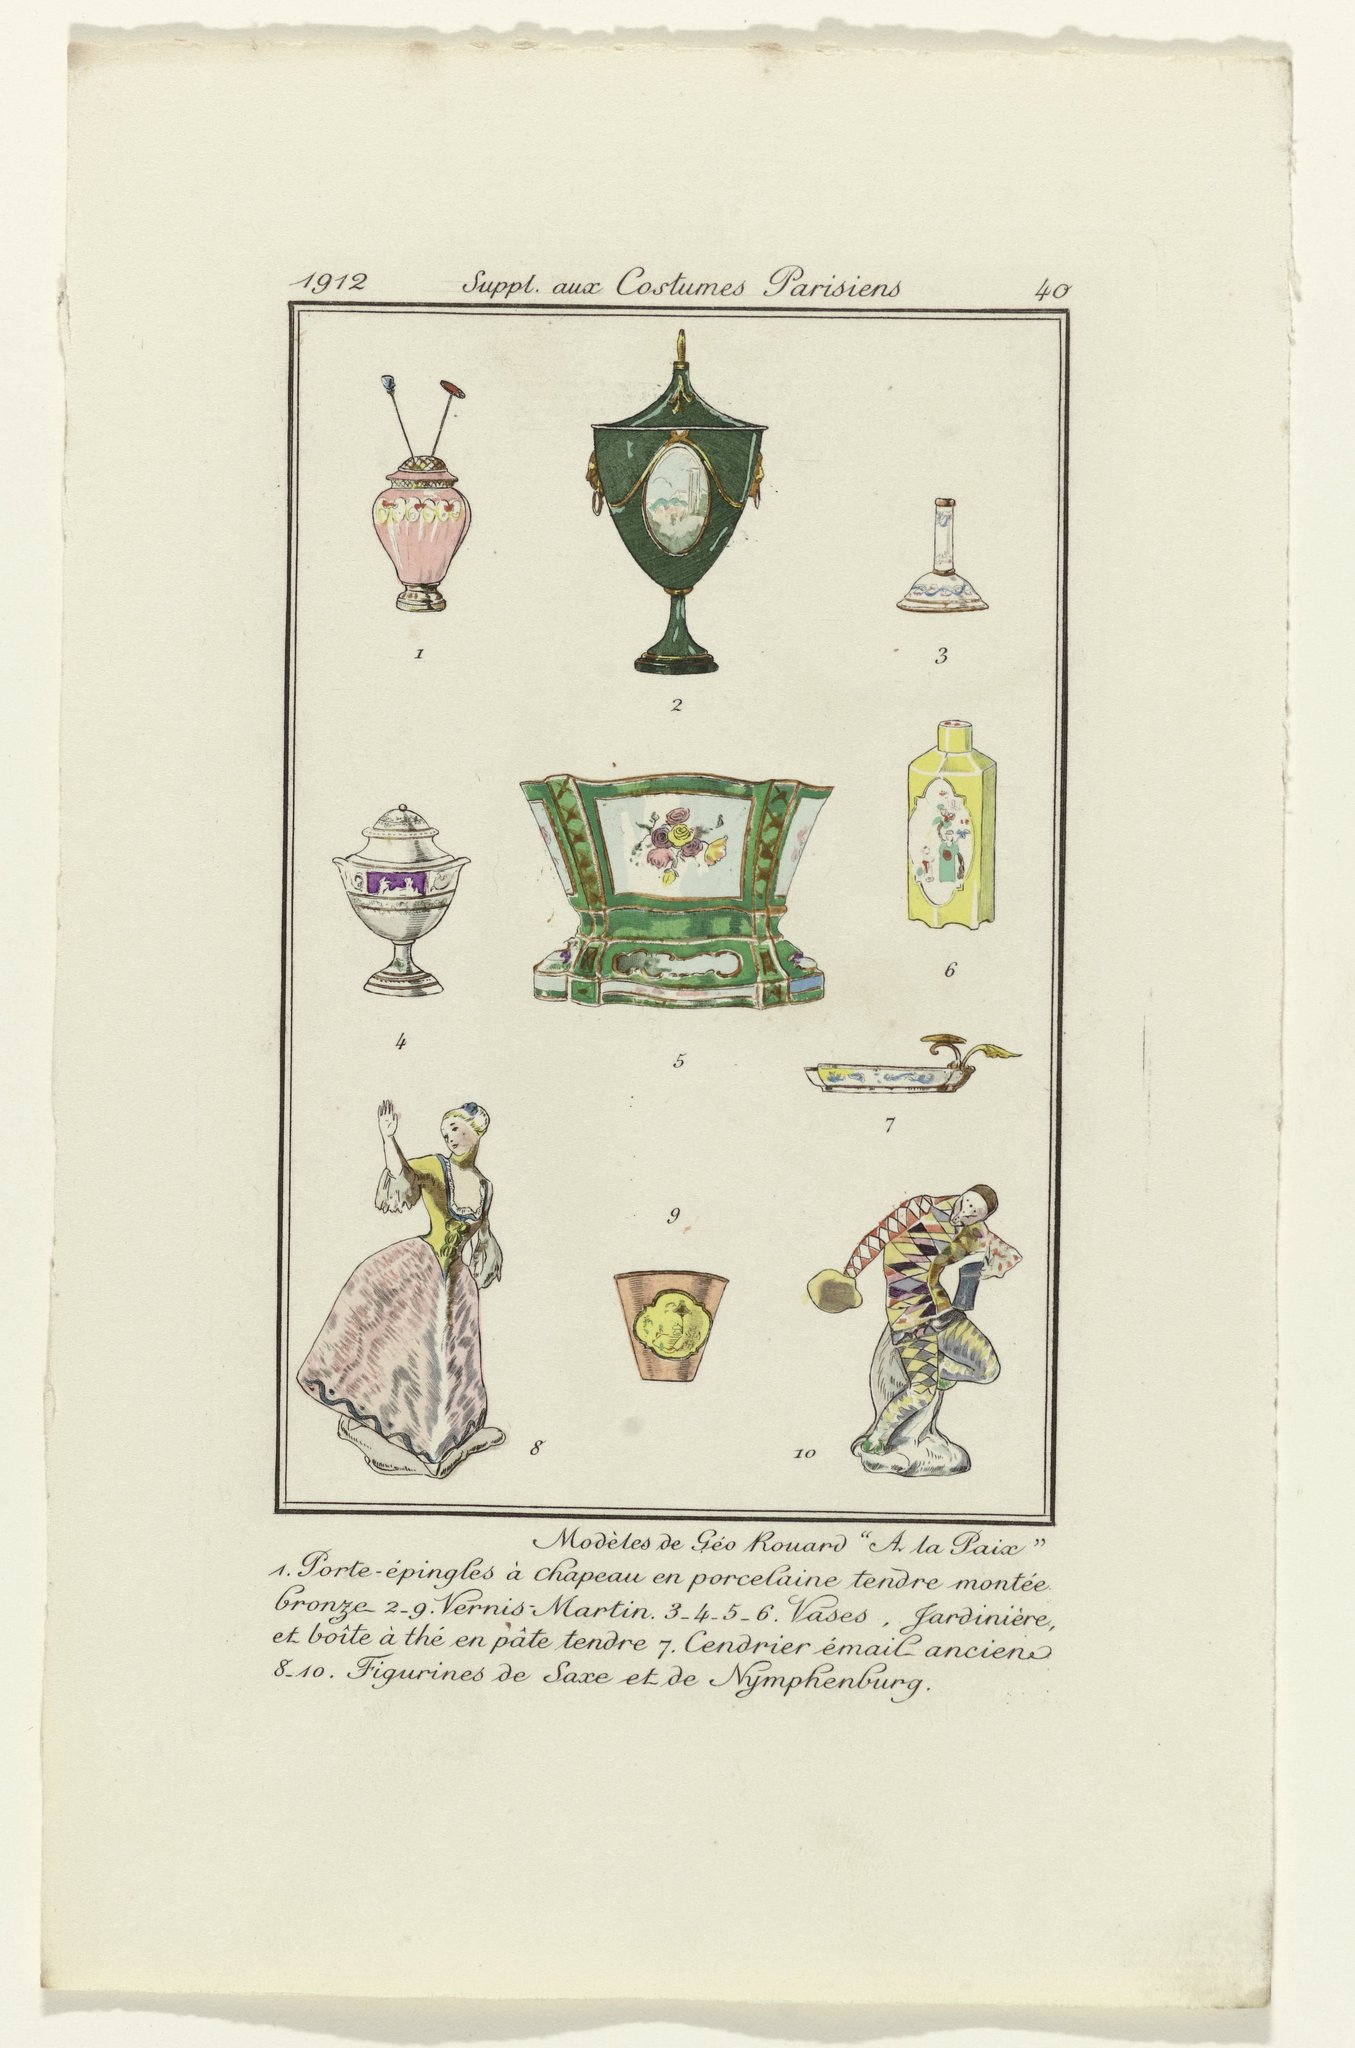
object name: fashion print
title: Journal des Dames et des Modes, 1912, Suppl. aux Costumes Parisiens, no. 40: Modèles de Geo Rouard "A la Paix"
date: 1912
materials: paper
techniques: engraving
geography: paris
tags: fashion plates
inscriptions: caption: ‘Robe de promenade en Sarah à damiers et taffetas peint à la main, bordée de velours noir: Chapeau de paille orné d'un panache en duvet de Cygne’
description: Beeldjes, vazen, asbakken etc. van Géo Rouard, Paris